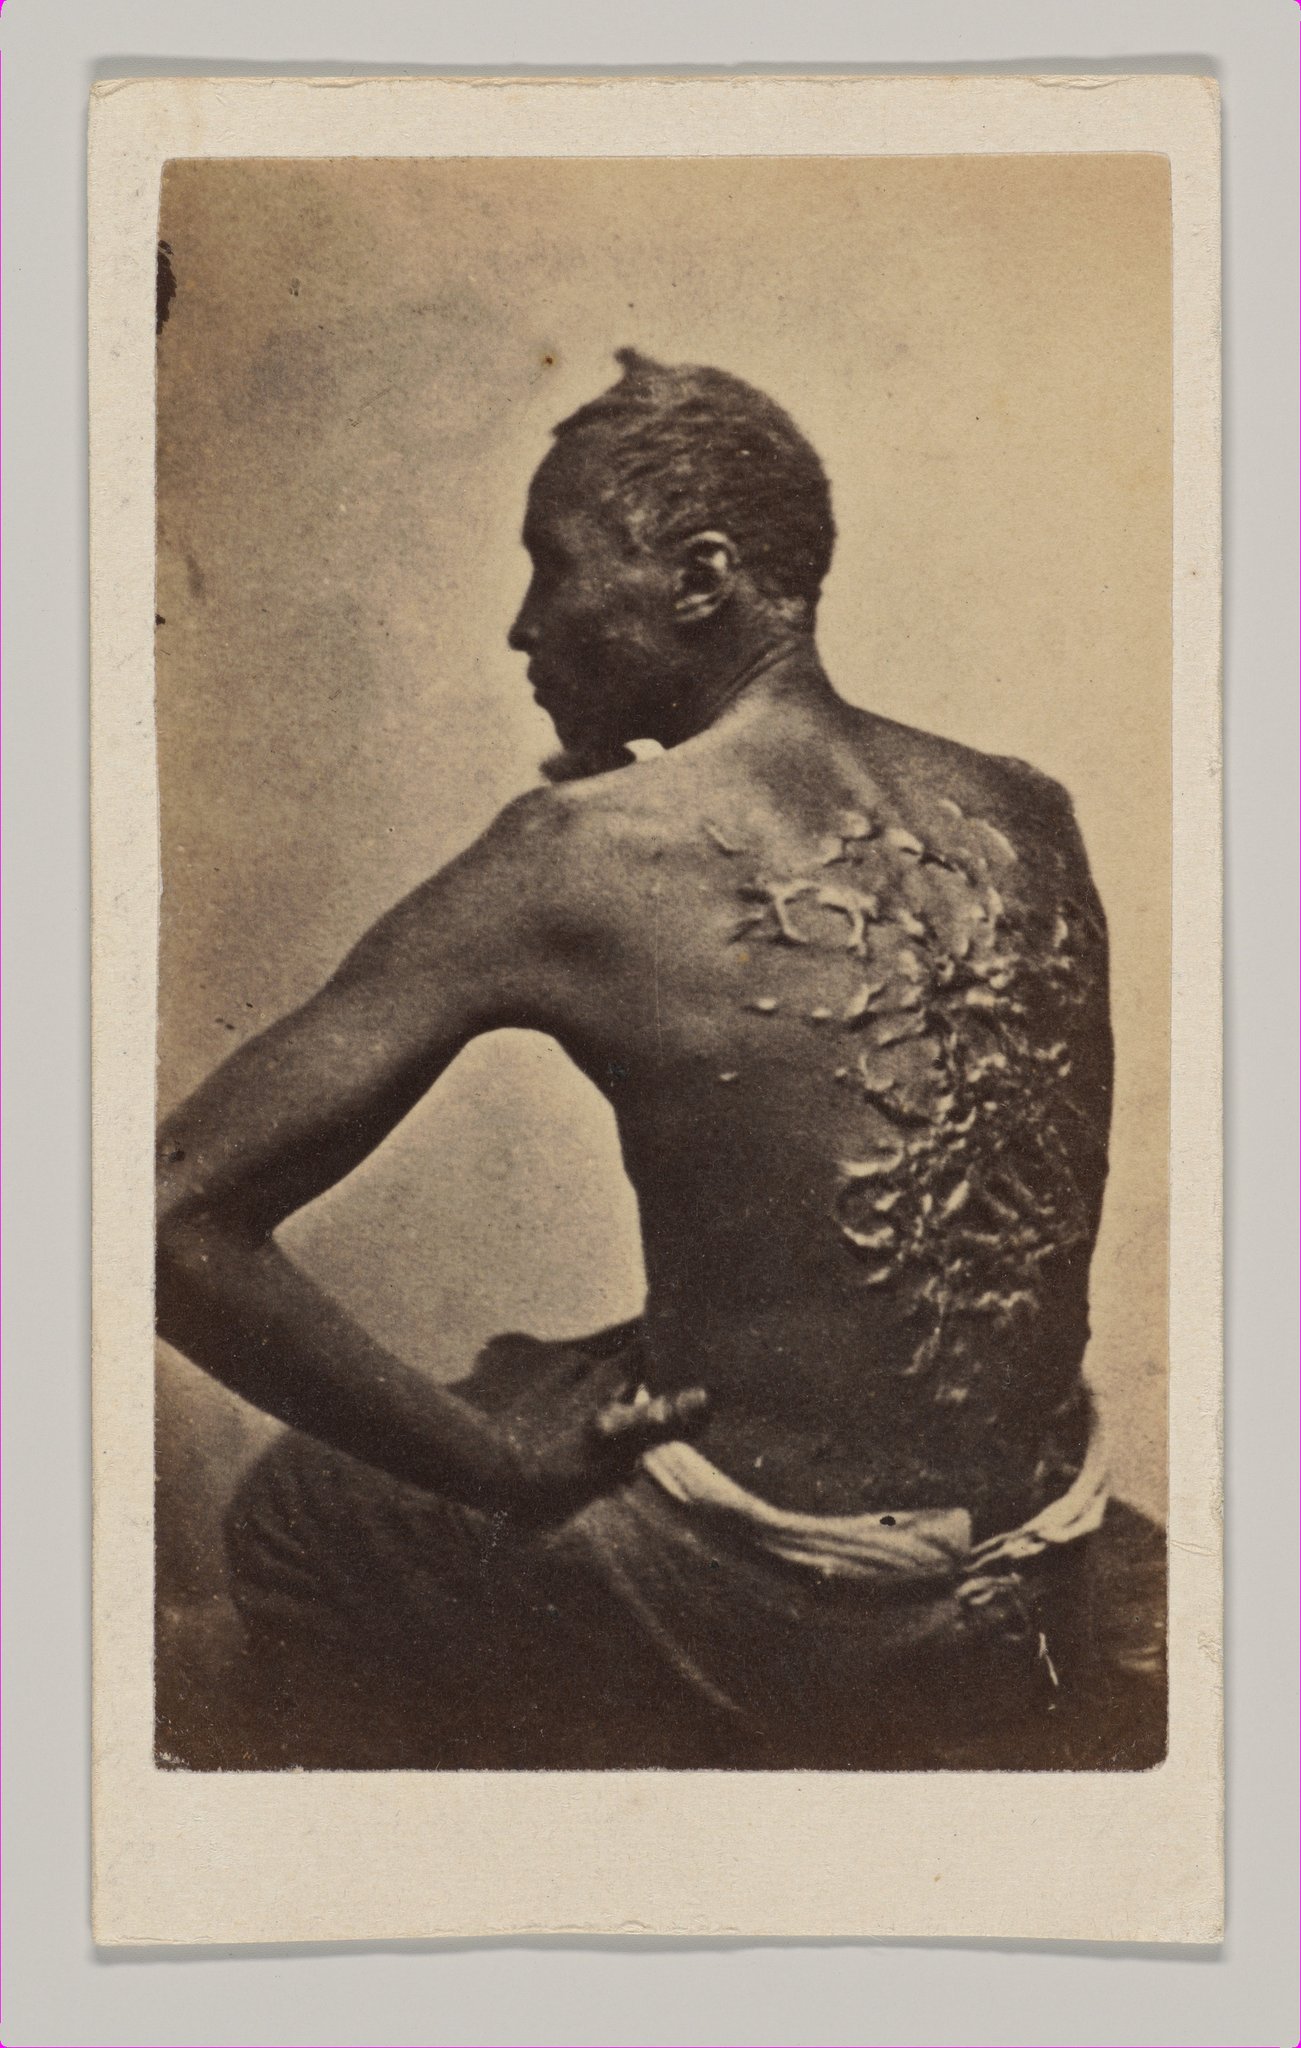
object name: carte de visite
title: Gordon, A Runaway Mississippi Slave, or "The Scourged Back"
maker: mcpherson & oliver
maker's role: artist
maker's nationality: american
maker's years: 1863-1865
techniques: albumen silver print, glass negative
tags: american civil war